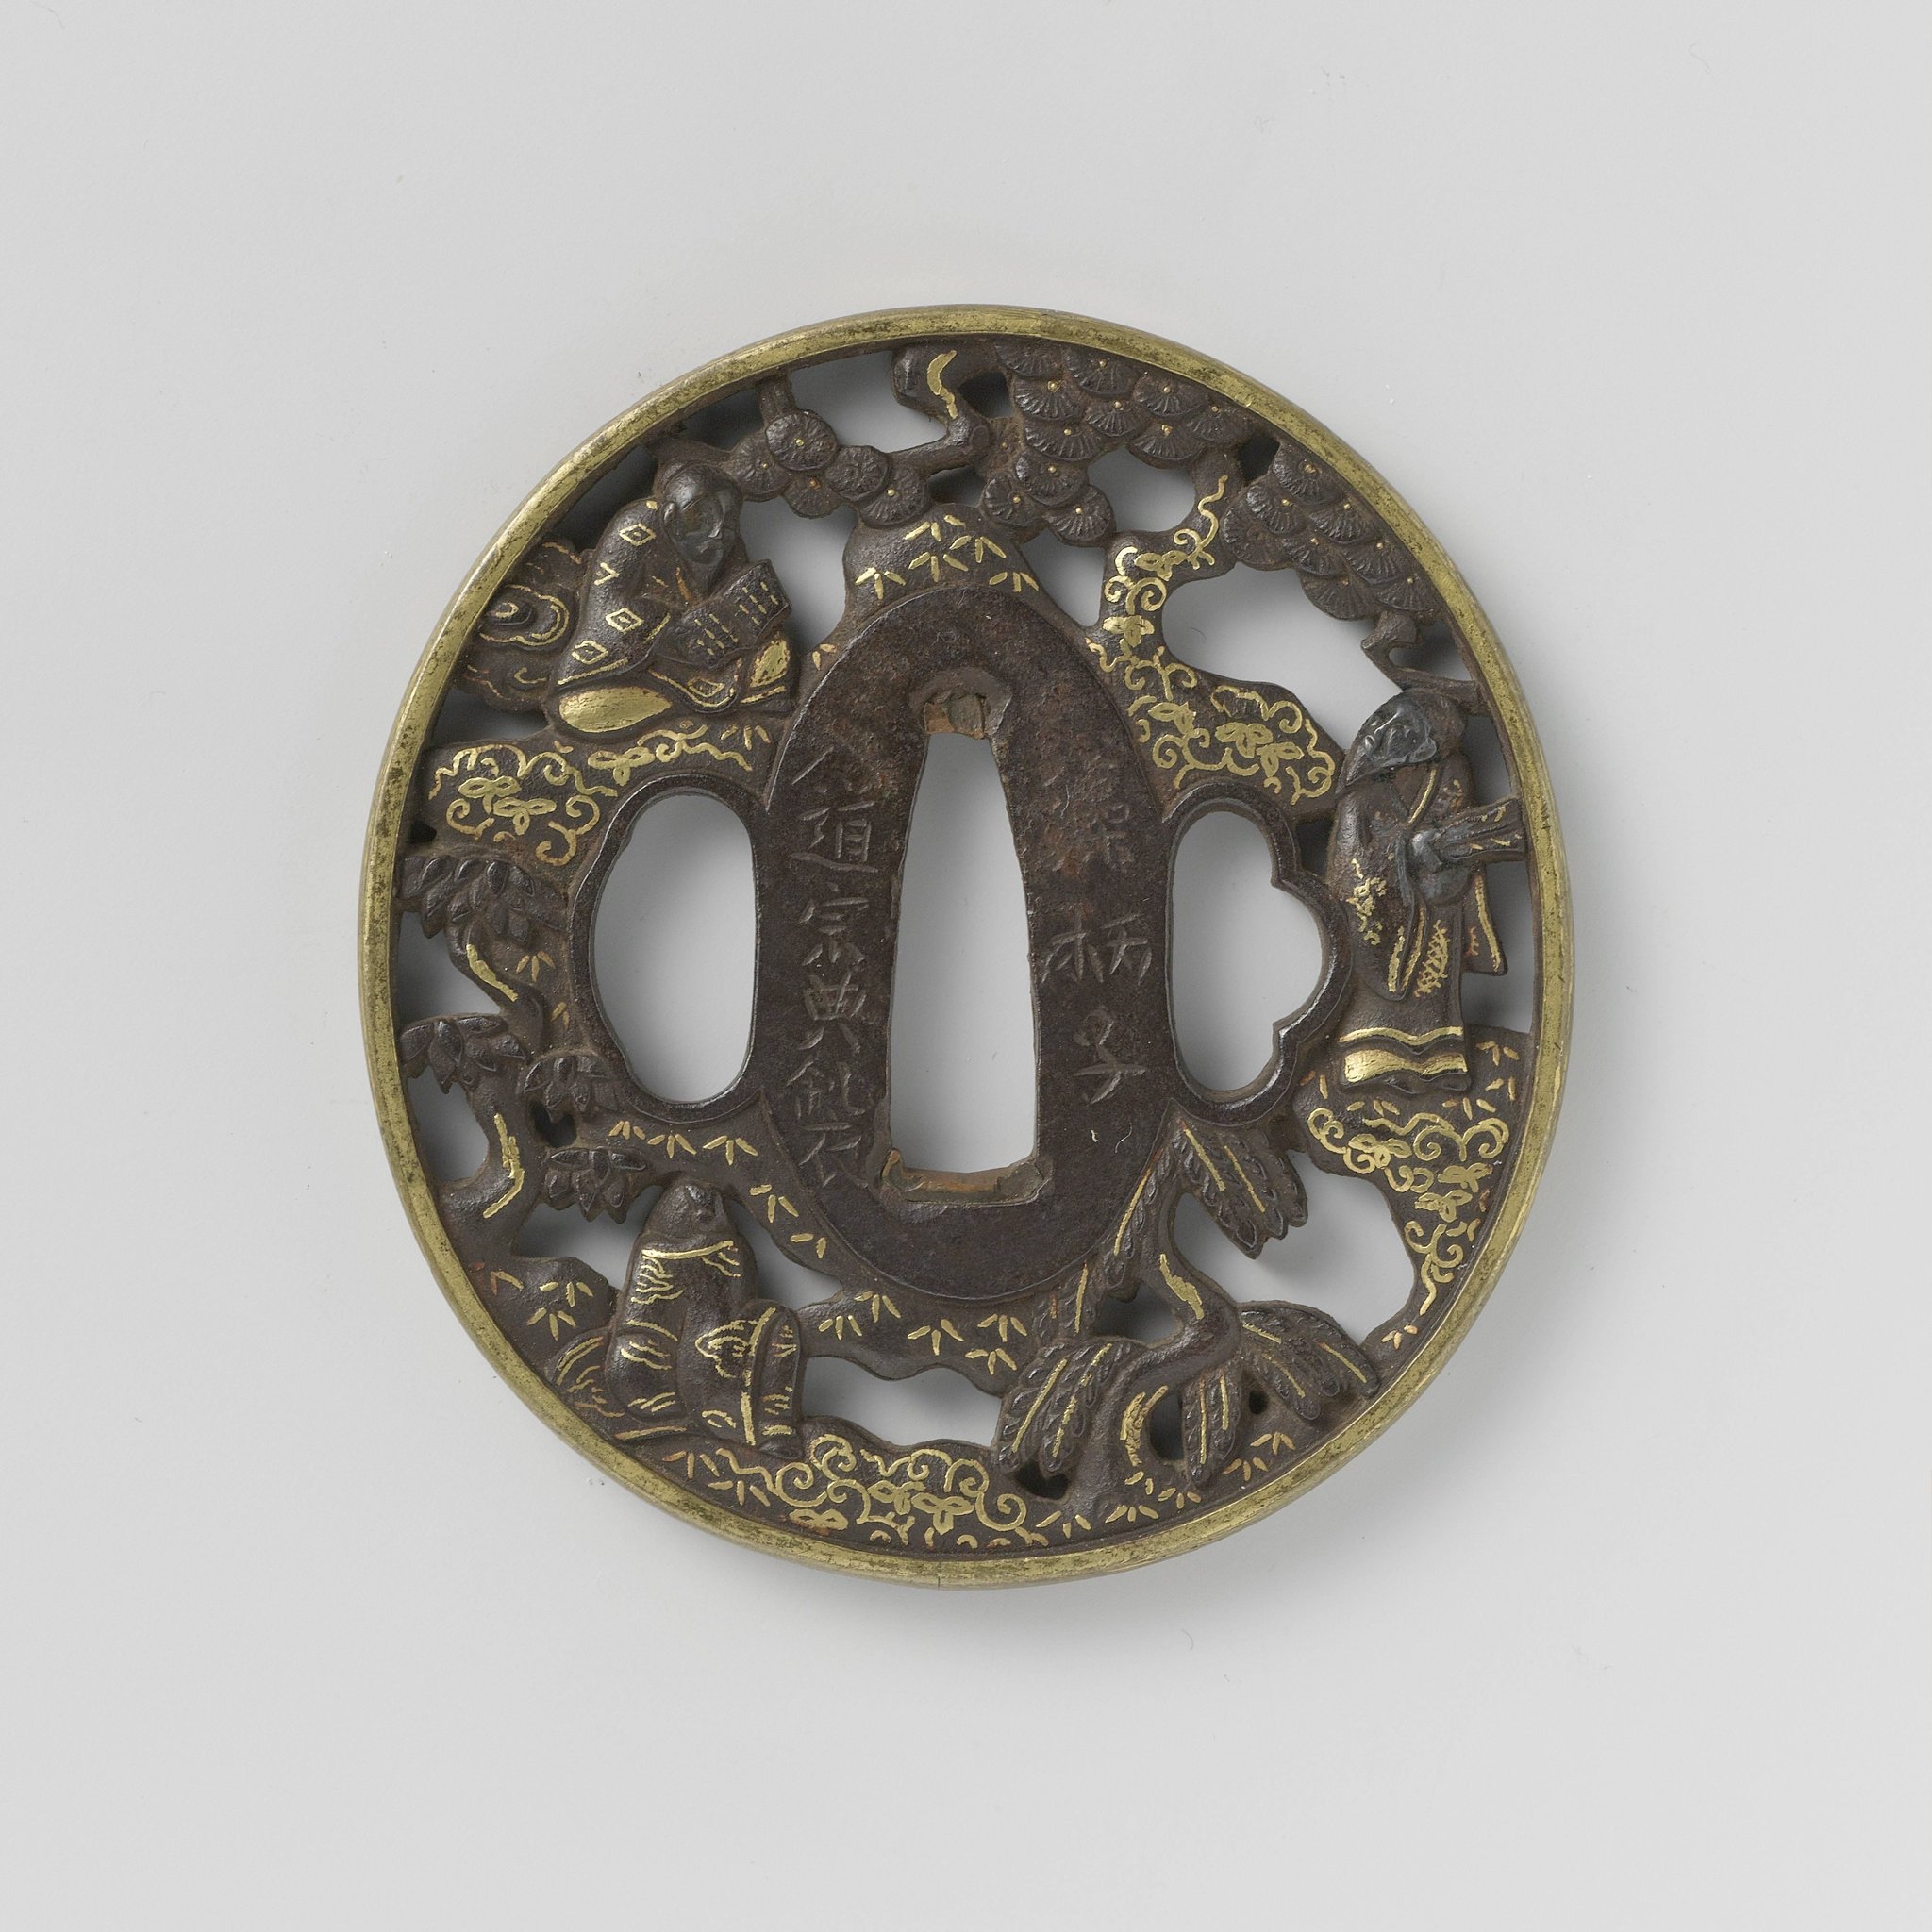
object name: tsuba, zwaardstootplaat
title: Hand guard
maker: soten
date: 1650-1700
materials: copper, gold, iron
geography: japan